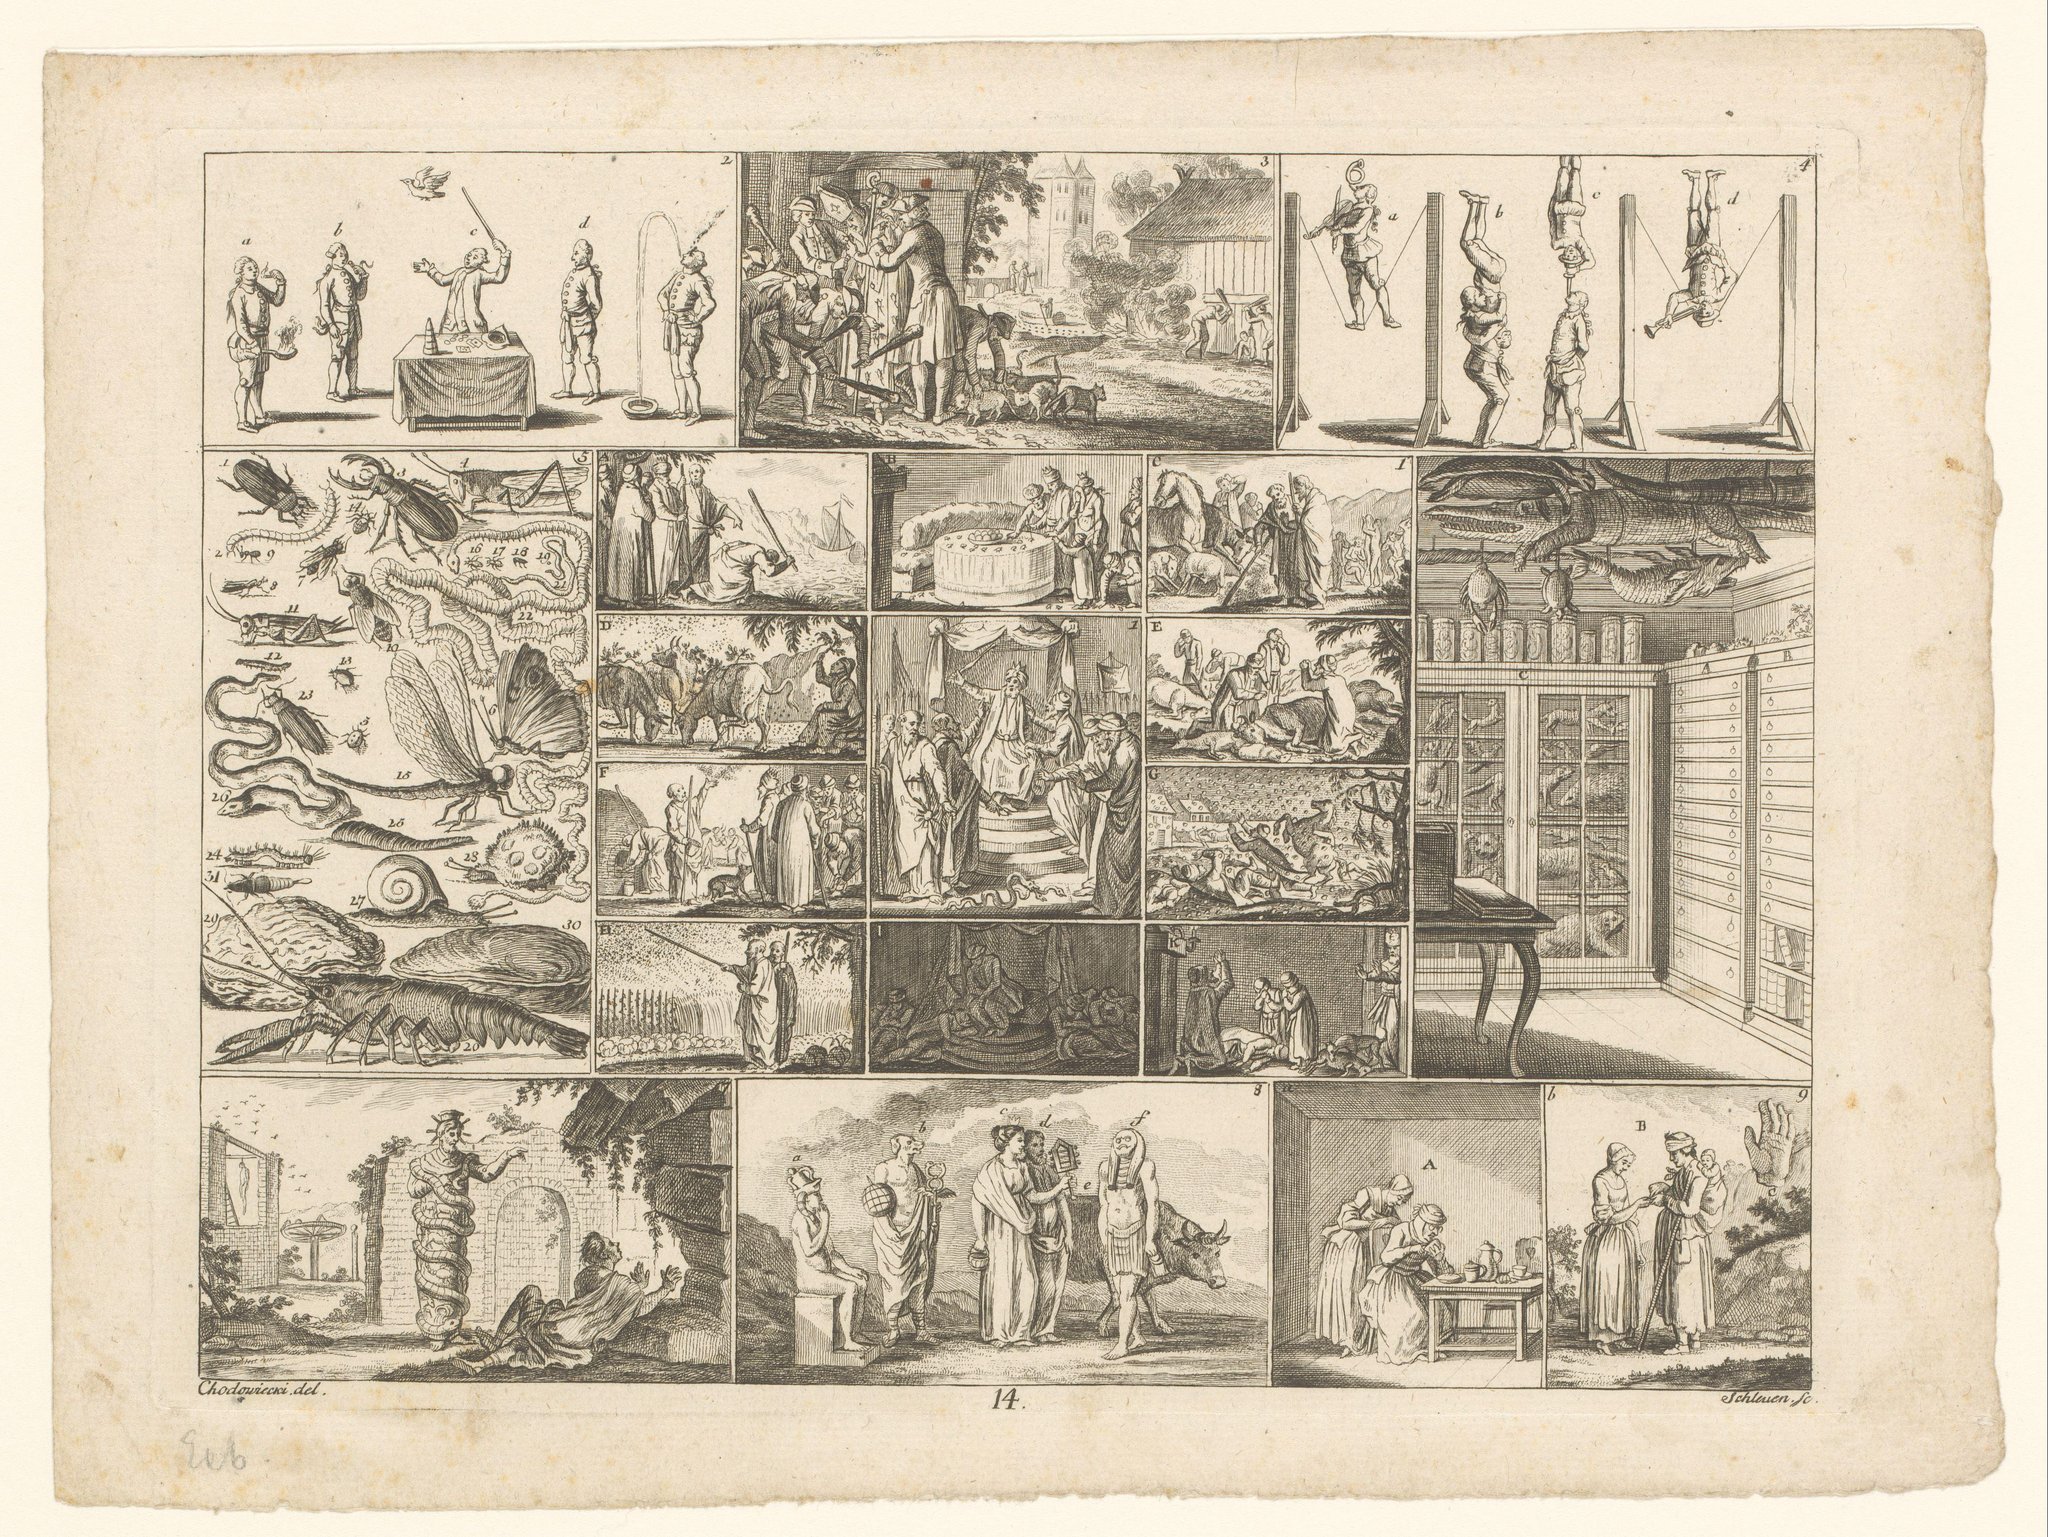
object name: print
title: Bilder-Akademie für die Jugend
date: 1784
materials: paper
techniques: engraving, etching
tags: moses and aaron before pharaoh; aaron performs the miracle of the rod changing into a snake, acrobat ~ circus, study; 'studiolo'; library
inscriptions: collector's mark: Lugt 2228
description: Maakt deel uit van een serie encyclopedische prenten door verschillende kunstenaars naar ontwerp van Daniel Nikolaus Chodowiecki bij Johann Sigmund Stoy's 'Bilder-Akademie für die Jugend', uitgegeven te Neurenberg in 1784. De prenten waren bedoeld voor kinderen om uit te knippen, op kaarten te plakken en vervolgens op logische wijze te rangschikken (zie Heesen, Anke te. The World in a Box: The Story of an Eighteenth-Century Picture Encyclopedia. Chicago: University of Chicago Press, 2002).